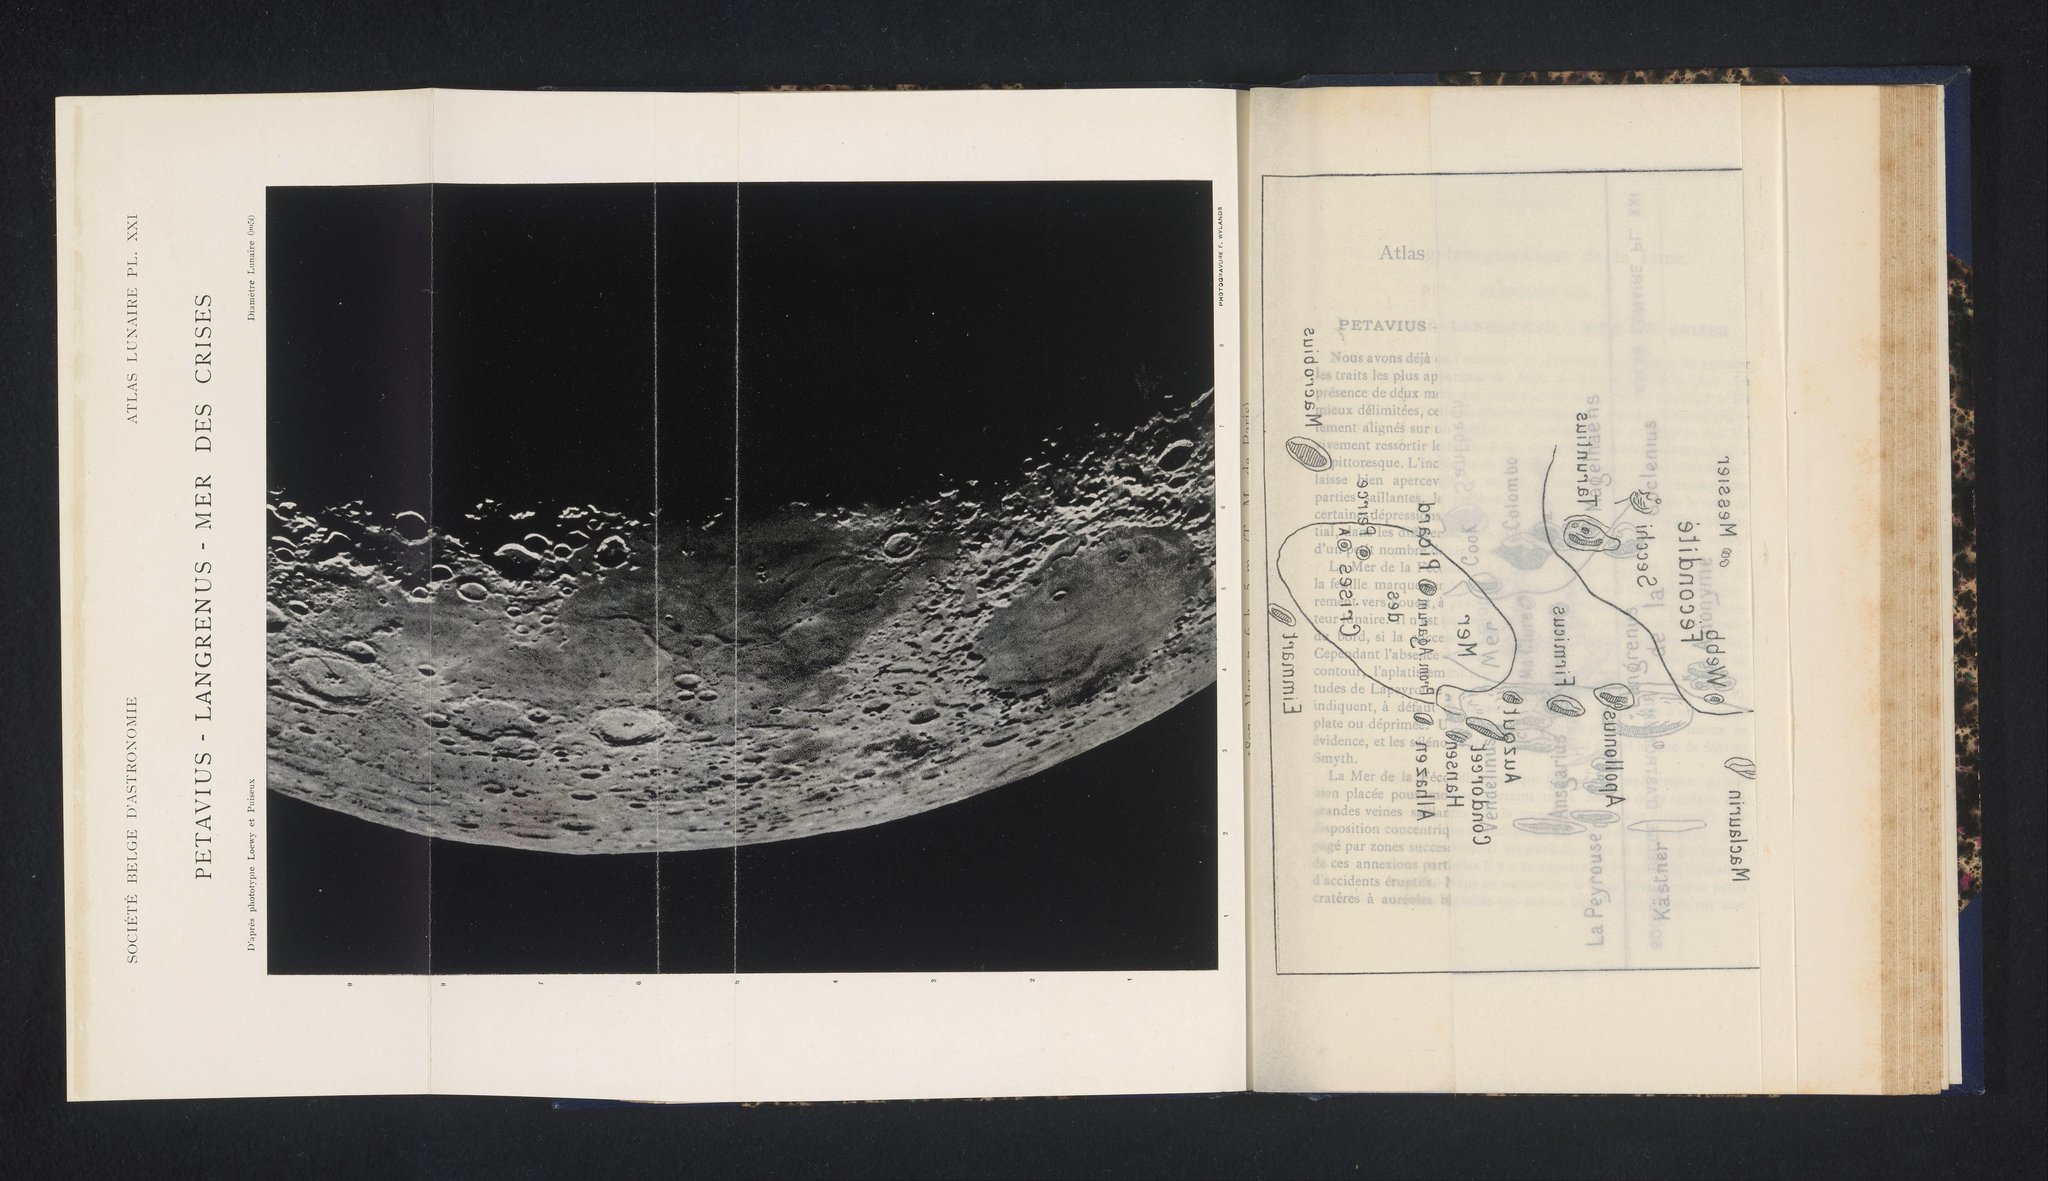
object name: photomechanical print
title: Petavius - Langrenus - Mer des Crises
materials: paper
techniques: autotype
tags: surface of the moon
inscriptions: inscription: ‘Société Belge D'Astronomie Atlas Lunaire Pl. XXI/ 1897, Mars 7, 6h. 5m. (T. M. de Paris)’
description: Transparante pagina voor prent als kaart met daarop de namen van de verschillende kraters.